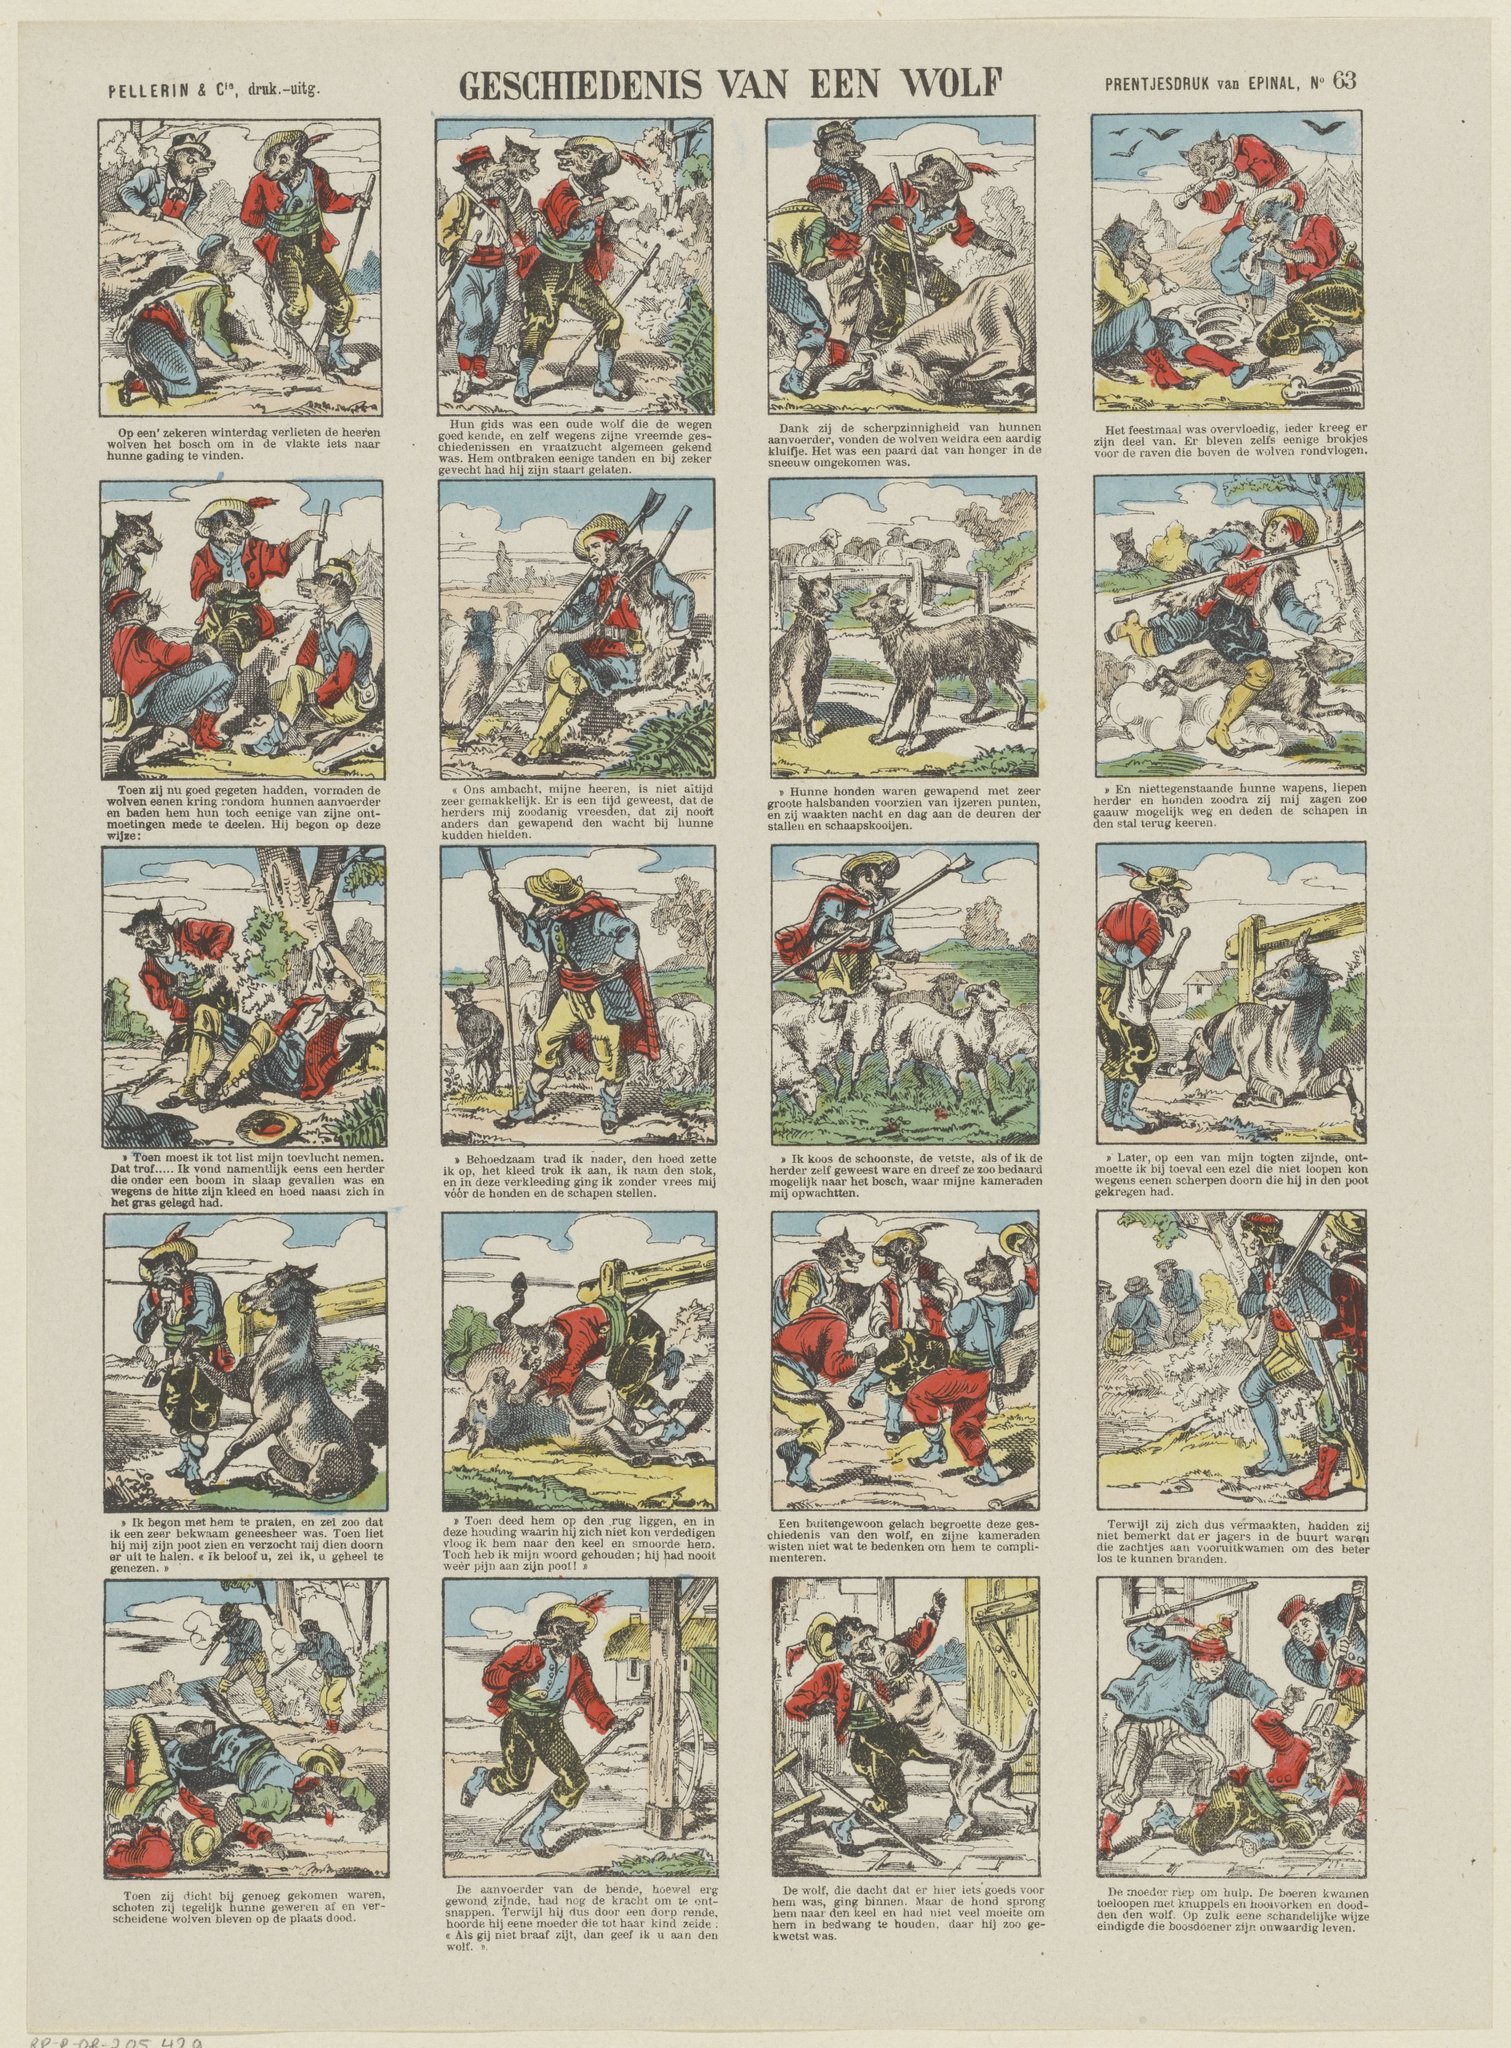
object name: popular print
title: Prentjesdruk van Épinal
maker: Anonymous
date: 1902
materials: paper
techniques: colour, letterpress printing, lithograph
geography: epinal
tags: animals acting as human beings, tales and fairy tales, beasts of prey, predatory animals: wolf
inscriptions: collector's mark: Lugt 2760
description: Blad met 20 voorstellingen over wolven die op andere dieren jagen. Onder elke afbeelding een onderschrift. Genummerd rechtsboven: No 63.